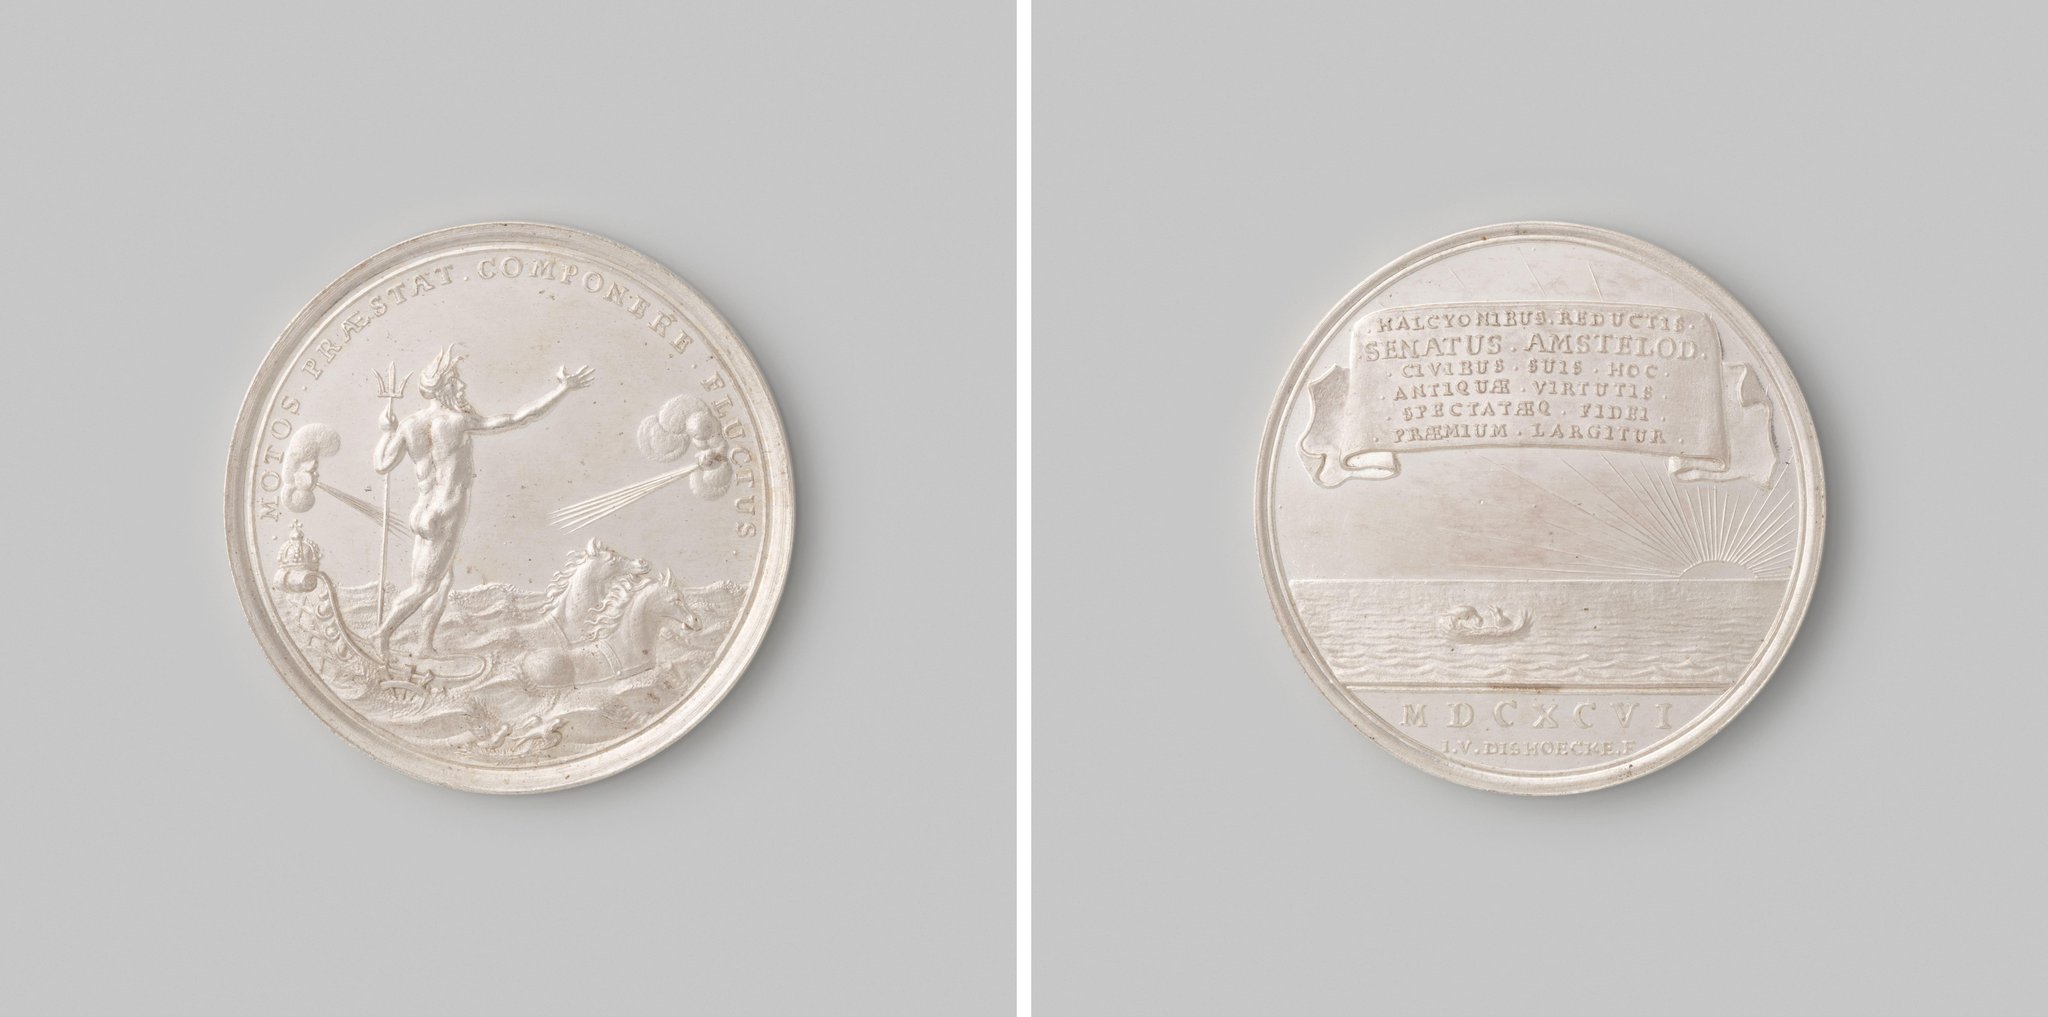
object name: history medal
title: Op de demping van het aansprekersoproer te Amsterdam naar aanleiding van de keur op het begraven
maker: jacob van dishoecke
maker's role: silversmith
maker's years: 1650-1723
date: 1696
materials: silver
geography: amsterdam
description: Zilveren penning, 3e grootte. Door de magistraat uitgereikt aan de schutters. Voorzijde: Neptunus bestraft de winden staande op zijn wagen met het stadswapen van Amsterdam met keizerskroon. Op de voorgrond twee vogels die uit het nest vallen. Omschrift: MOTOS PRAESTAT COMPONERE FLVCTVS (Beter om de in beroering gebrachte golven te bedaren). Keerzijde: twee vogels in een nest op kalme zee, terwijl de zon in de verte oprijst uit het water. Wimpel met opschrift: HALCYONIBVS REDVCTIS/ SENATVS AMSTELOD(AMENSIS)/ CIVIBVS SVIS HOC/ ANTIQVAE VIRTVTIS/ SPECTATAE Q/ (VE) FIDEI/ PRAEMIVM LARGITVR (Nadat de ijsvogels teruggevoerd zijn heeft de regering van Amsterdam aan hare [gewapende] burgers deze beloning gegeven voor hun oudvaderlijke dapperheid en hun beproefde trouw). Afsnede: MDCXCVI (1696) J. V. DISHOECKE F.(ecit). Variant. Bijbehorend: een zilveren doos, het deksel versierd met een familiewapen.